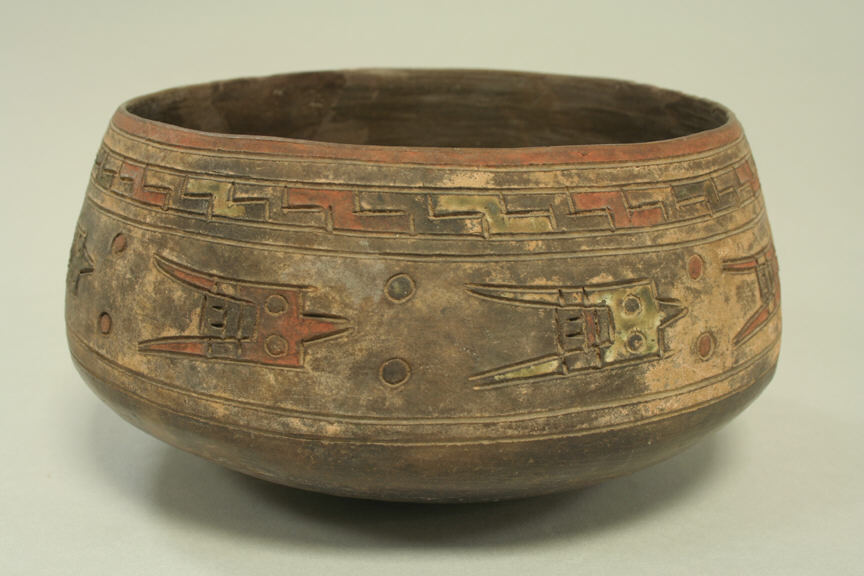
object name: bowl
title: Incised Painted Bowl with Birds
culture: paracas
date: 500-101 BCE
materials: ceramic, pigment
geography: peru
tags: birds